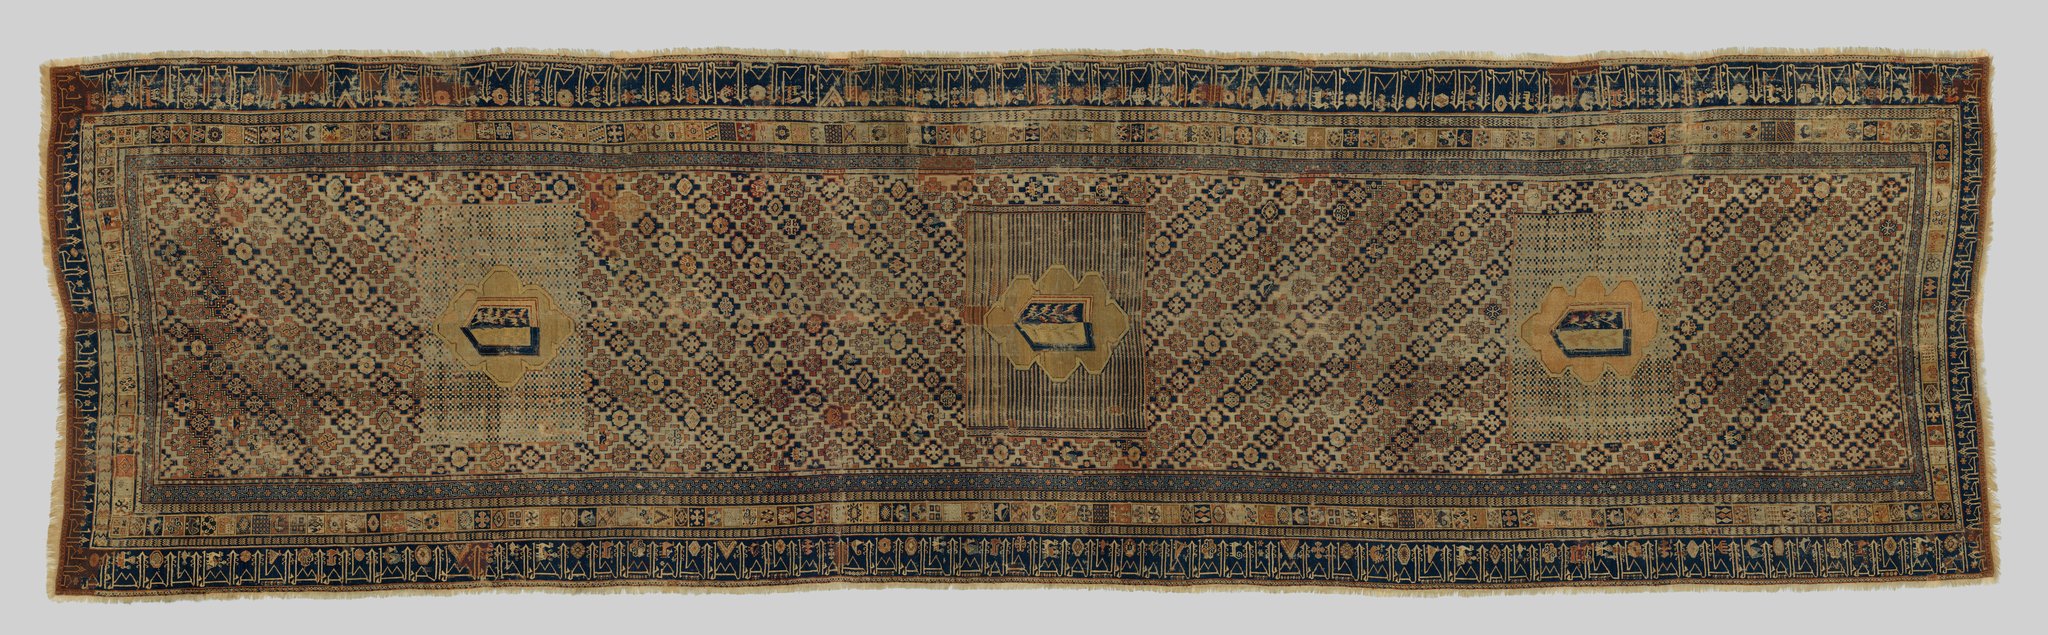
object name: carpet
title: Carpet with Coat of Arms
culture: spanish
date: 1401-1500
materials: wool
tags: coat of arms